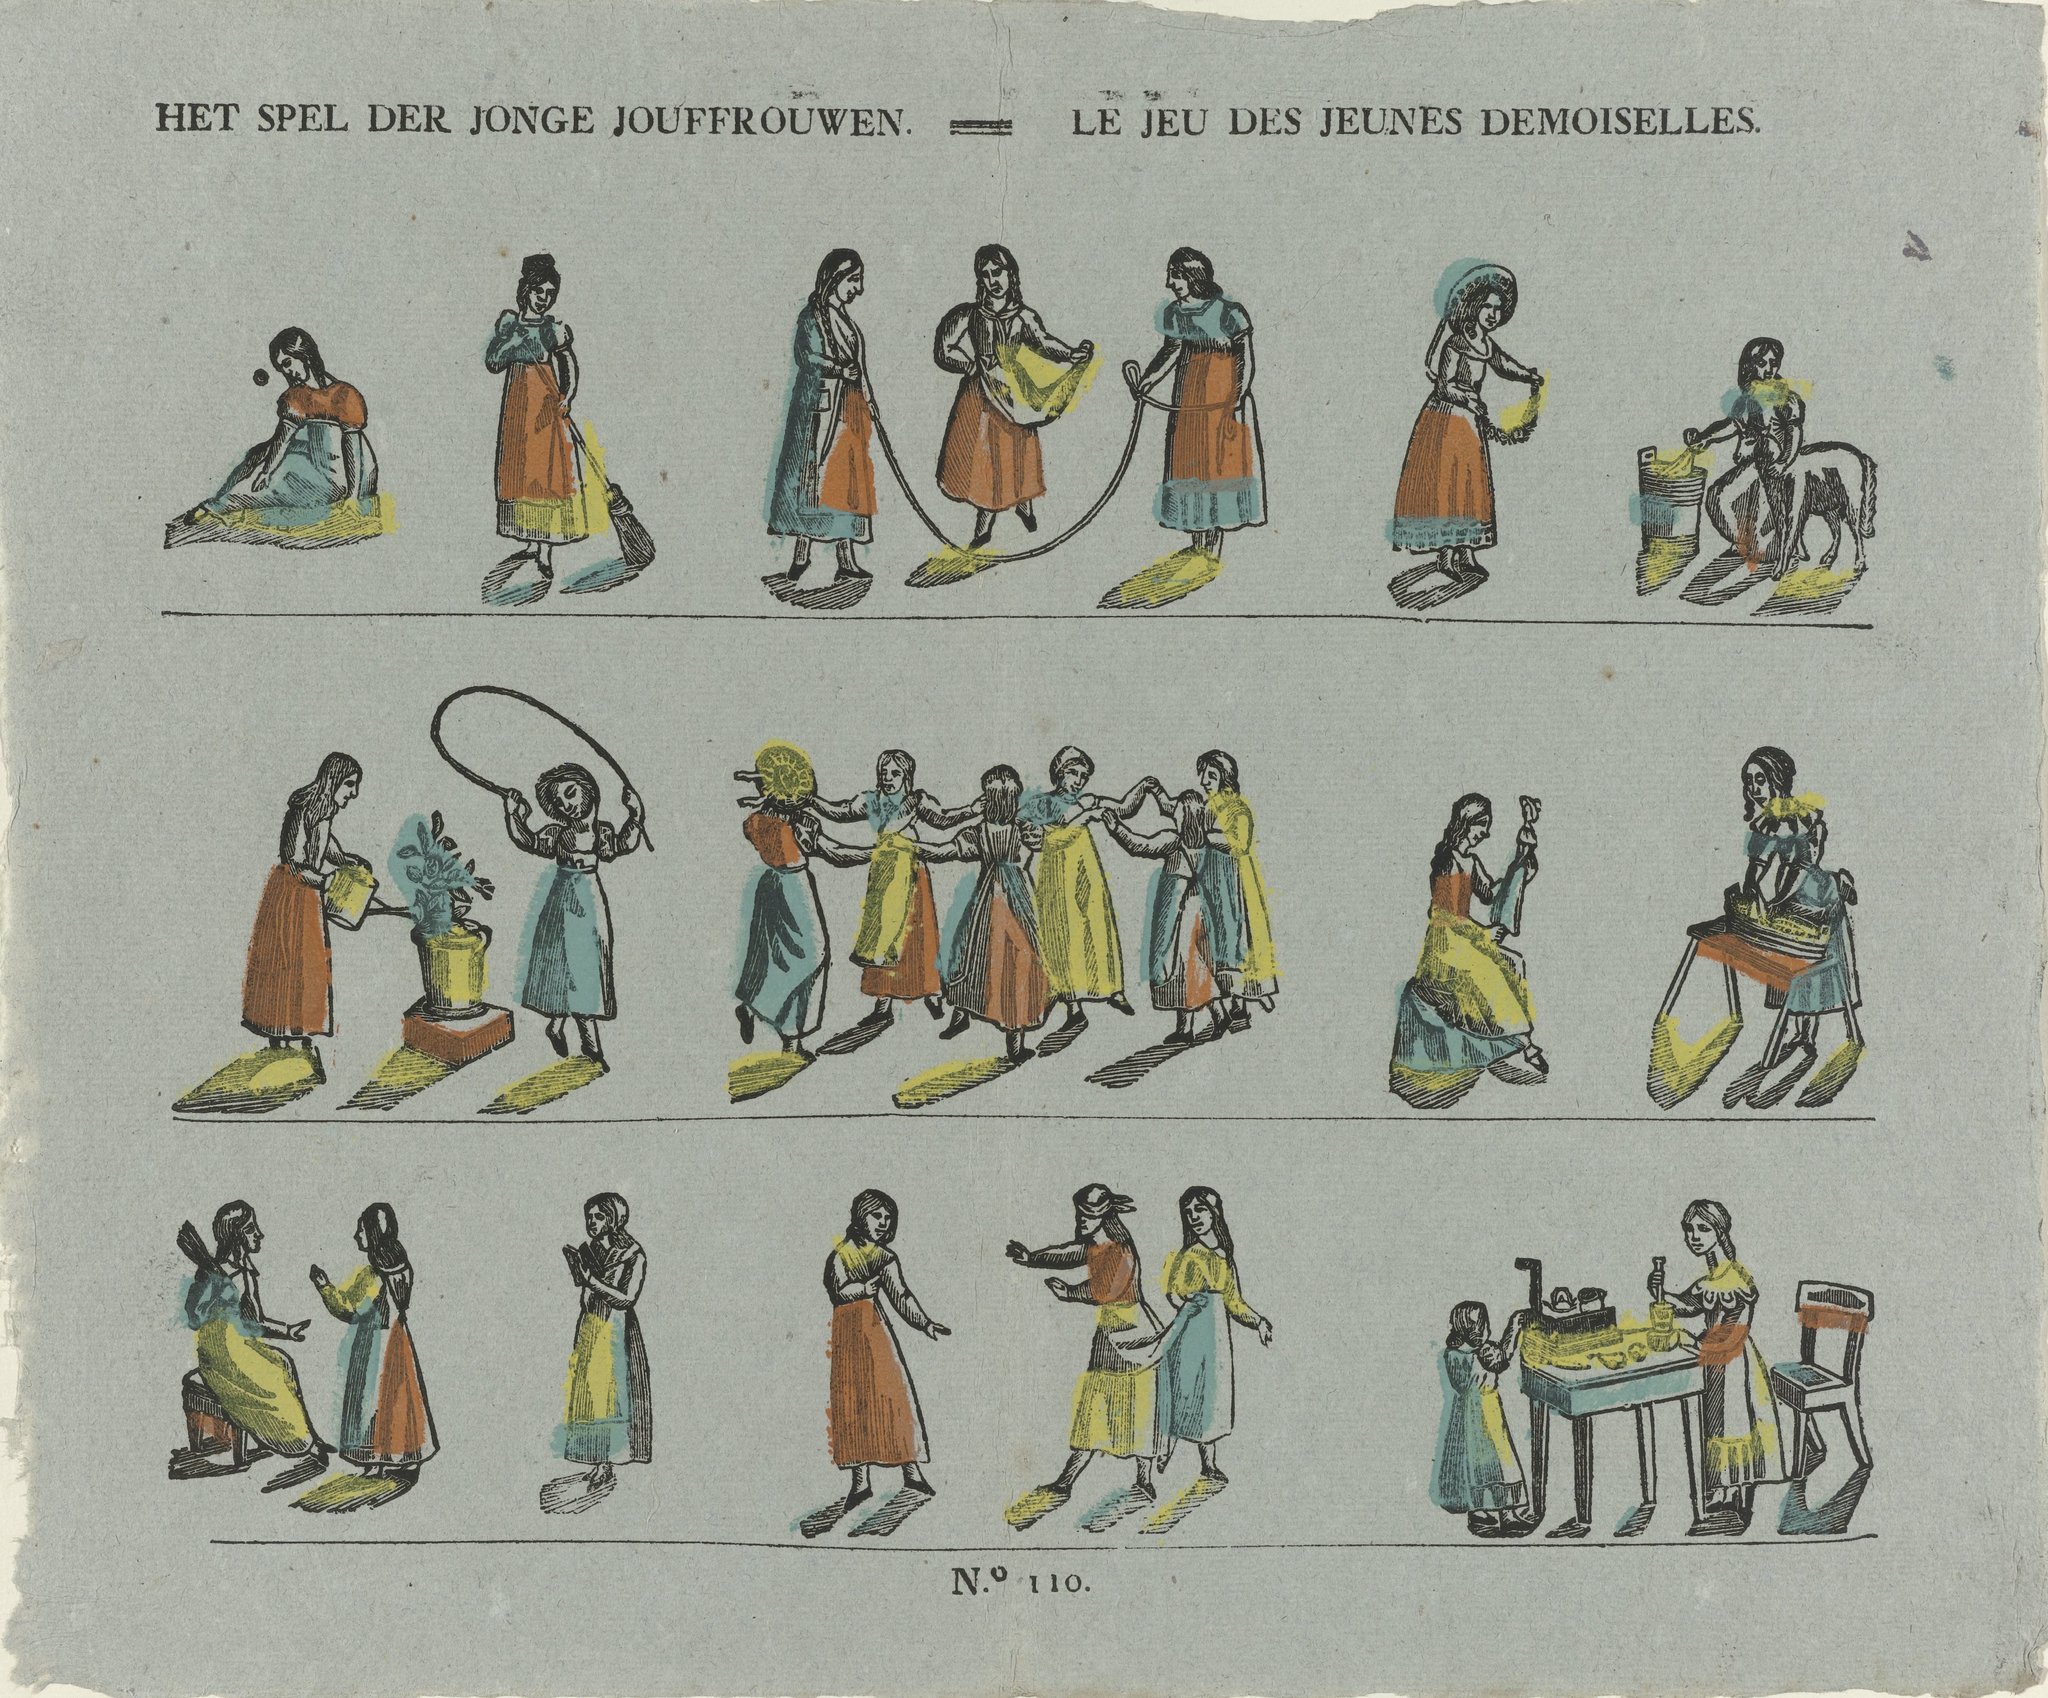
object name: popular print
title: Het spel der jonge juffrouwen / Le jeu des jeunes demoiselles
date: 1800-1833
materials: paper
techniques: colour, letterpress printing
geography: turnhout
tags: children's games and plays, dancing, jumping-rope games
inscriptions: collector's mark: Lugt 2760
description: Blad met 3 horizontale rijen met voorstellingen van spelen en bezigheden voor jonge vrouwen. Genummerd midden onder: No. 110.